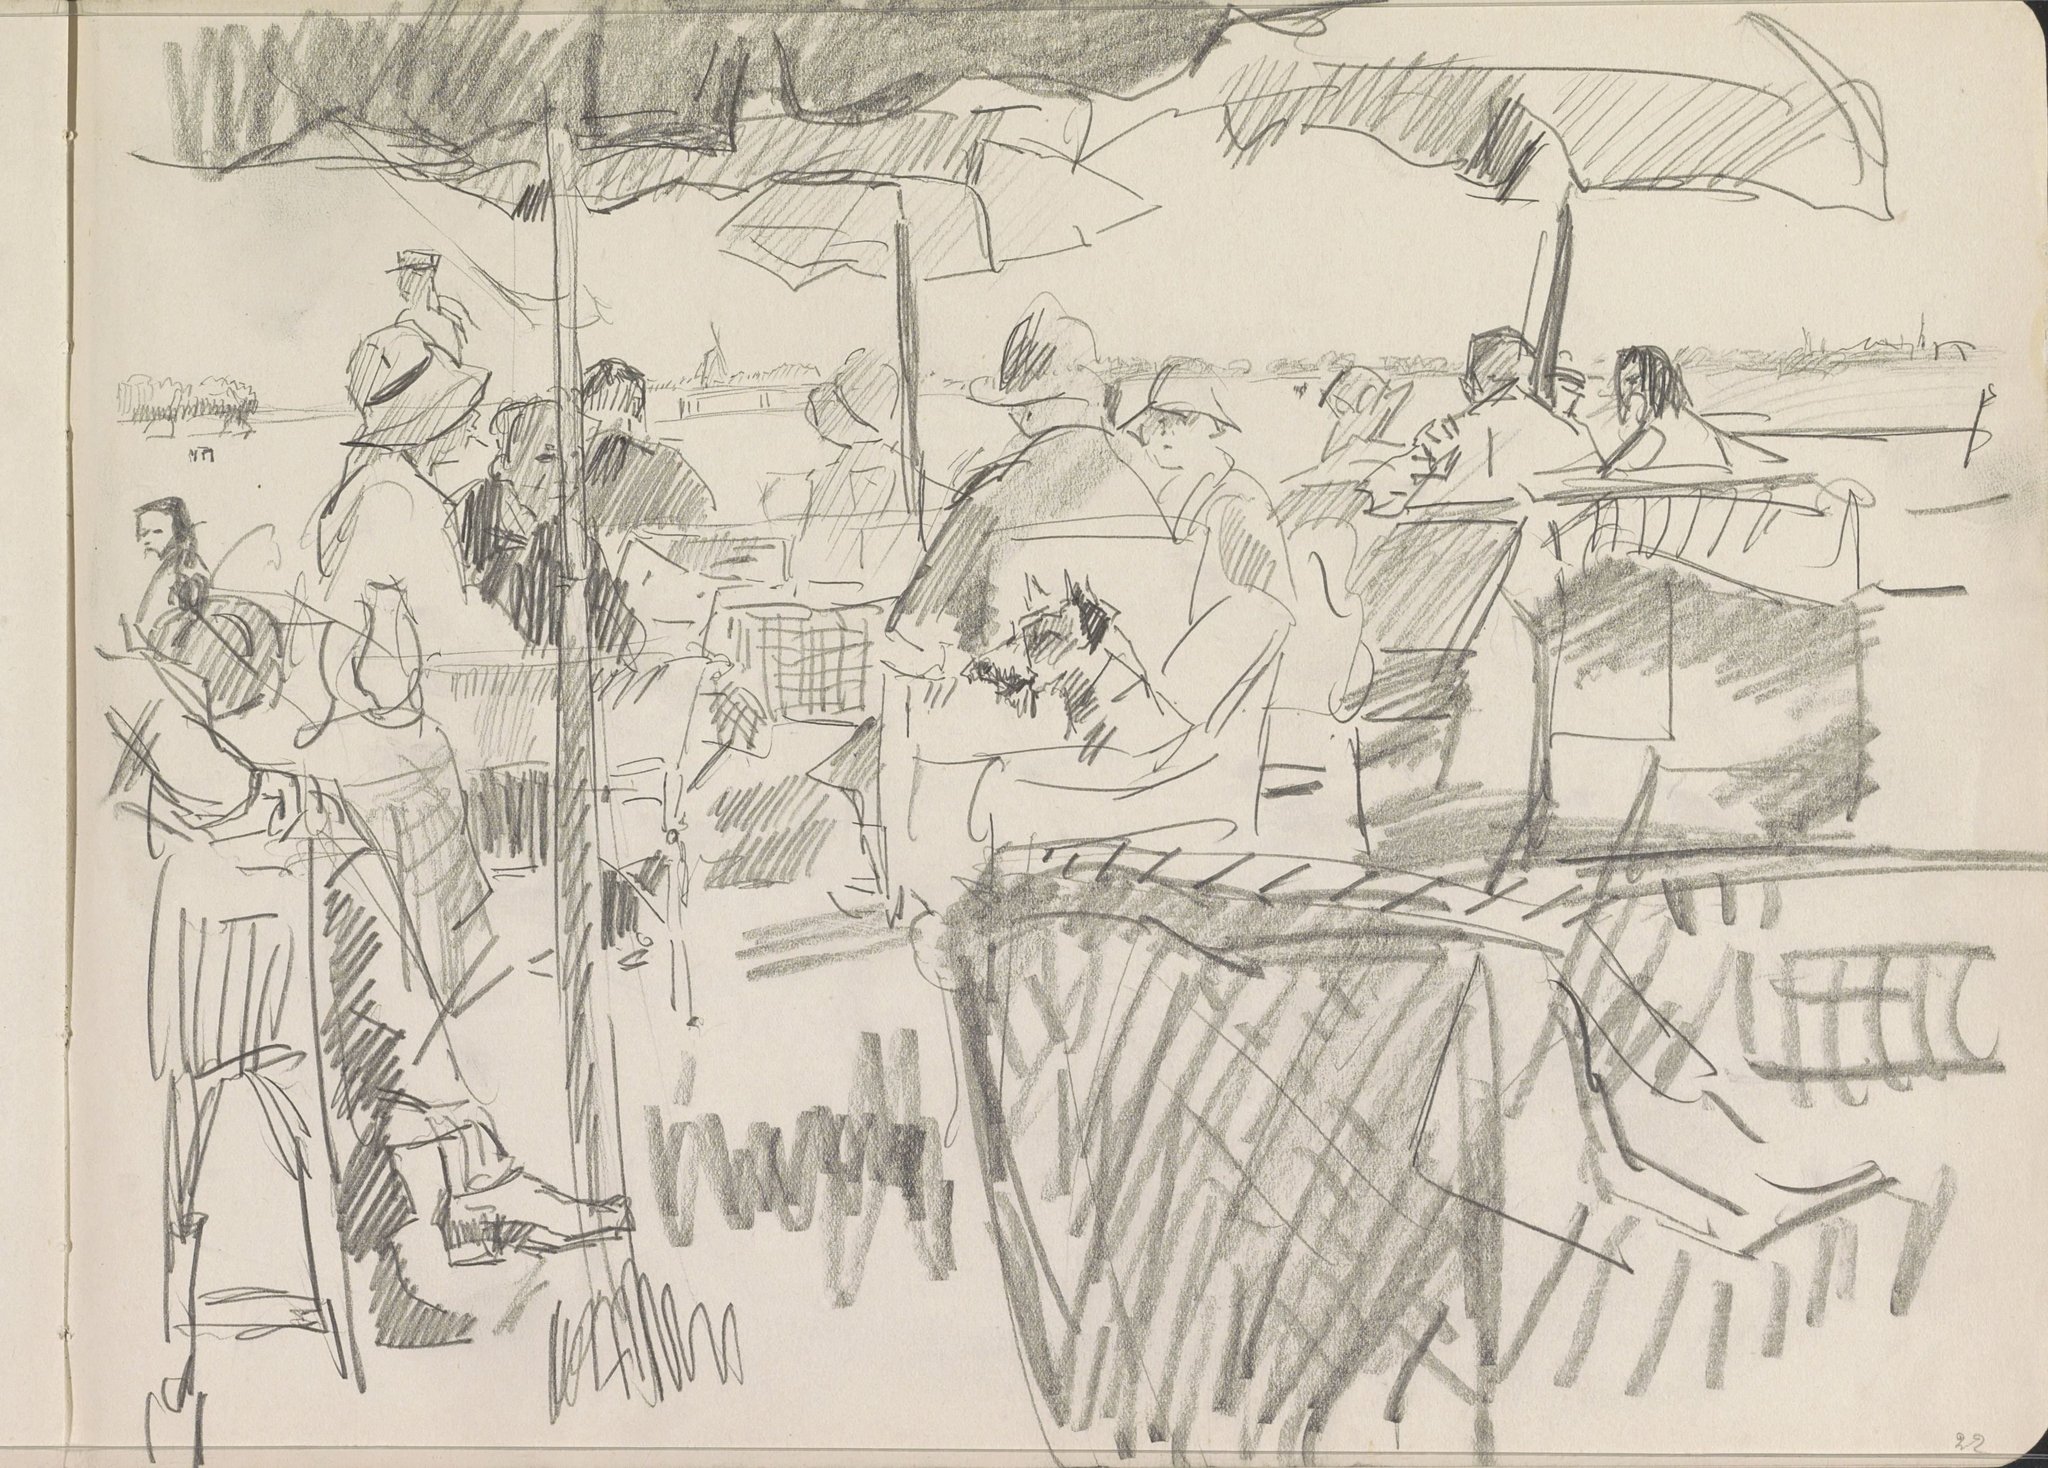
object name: sketchbook leaf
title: Terras aan het water, mogelijk bij Voorburg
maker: isaac israels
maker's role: draughtsman, painter, print maker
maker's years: 1865-1934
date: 1875-1934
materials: paper, pencil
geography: voorburg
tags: pavement, terrace in front of inn or restaurant, quay (+ city(-scape) with figures, staffage), voorburg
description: In de verte een molen. Blad 22 recto uit schetsboek II met 23 bladen.